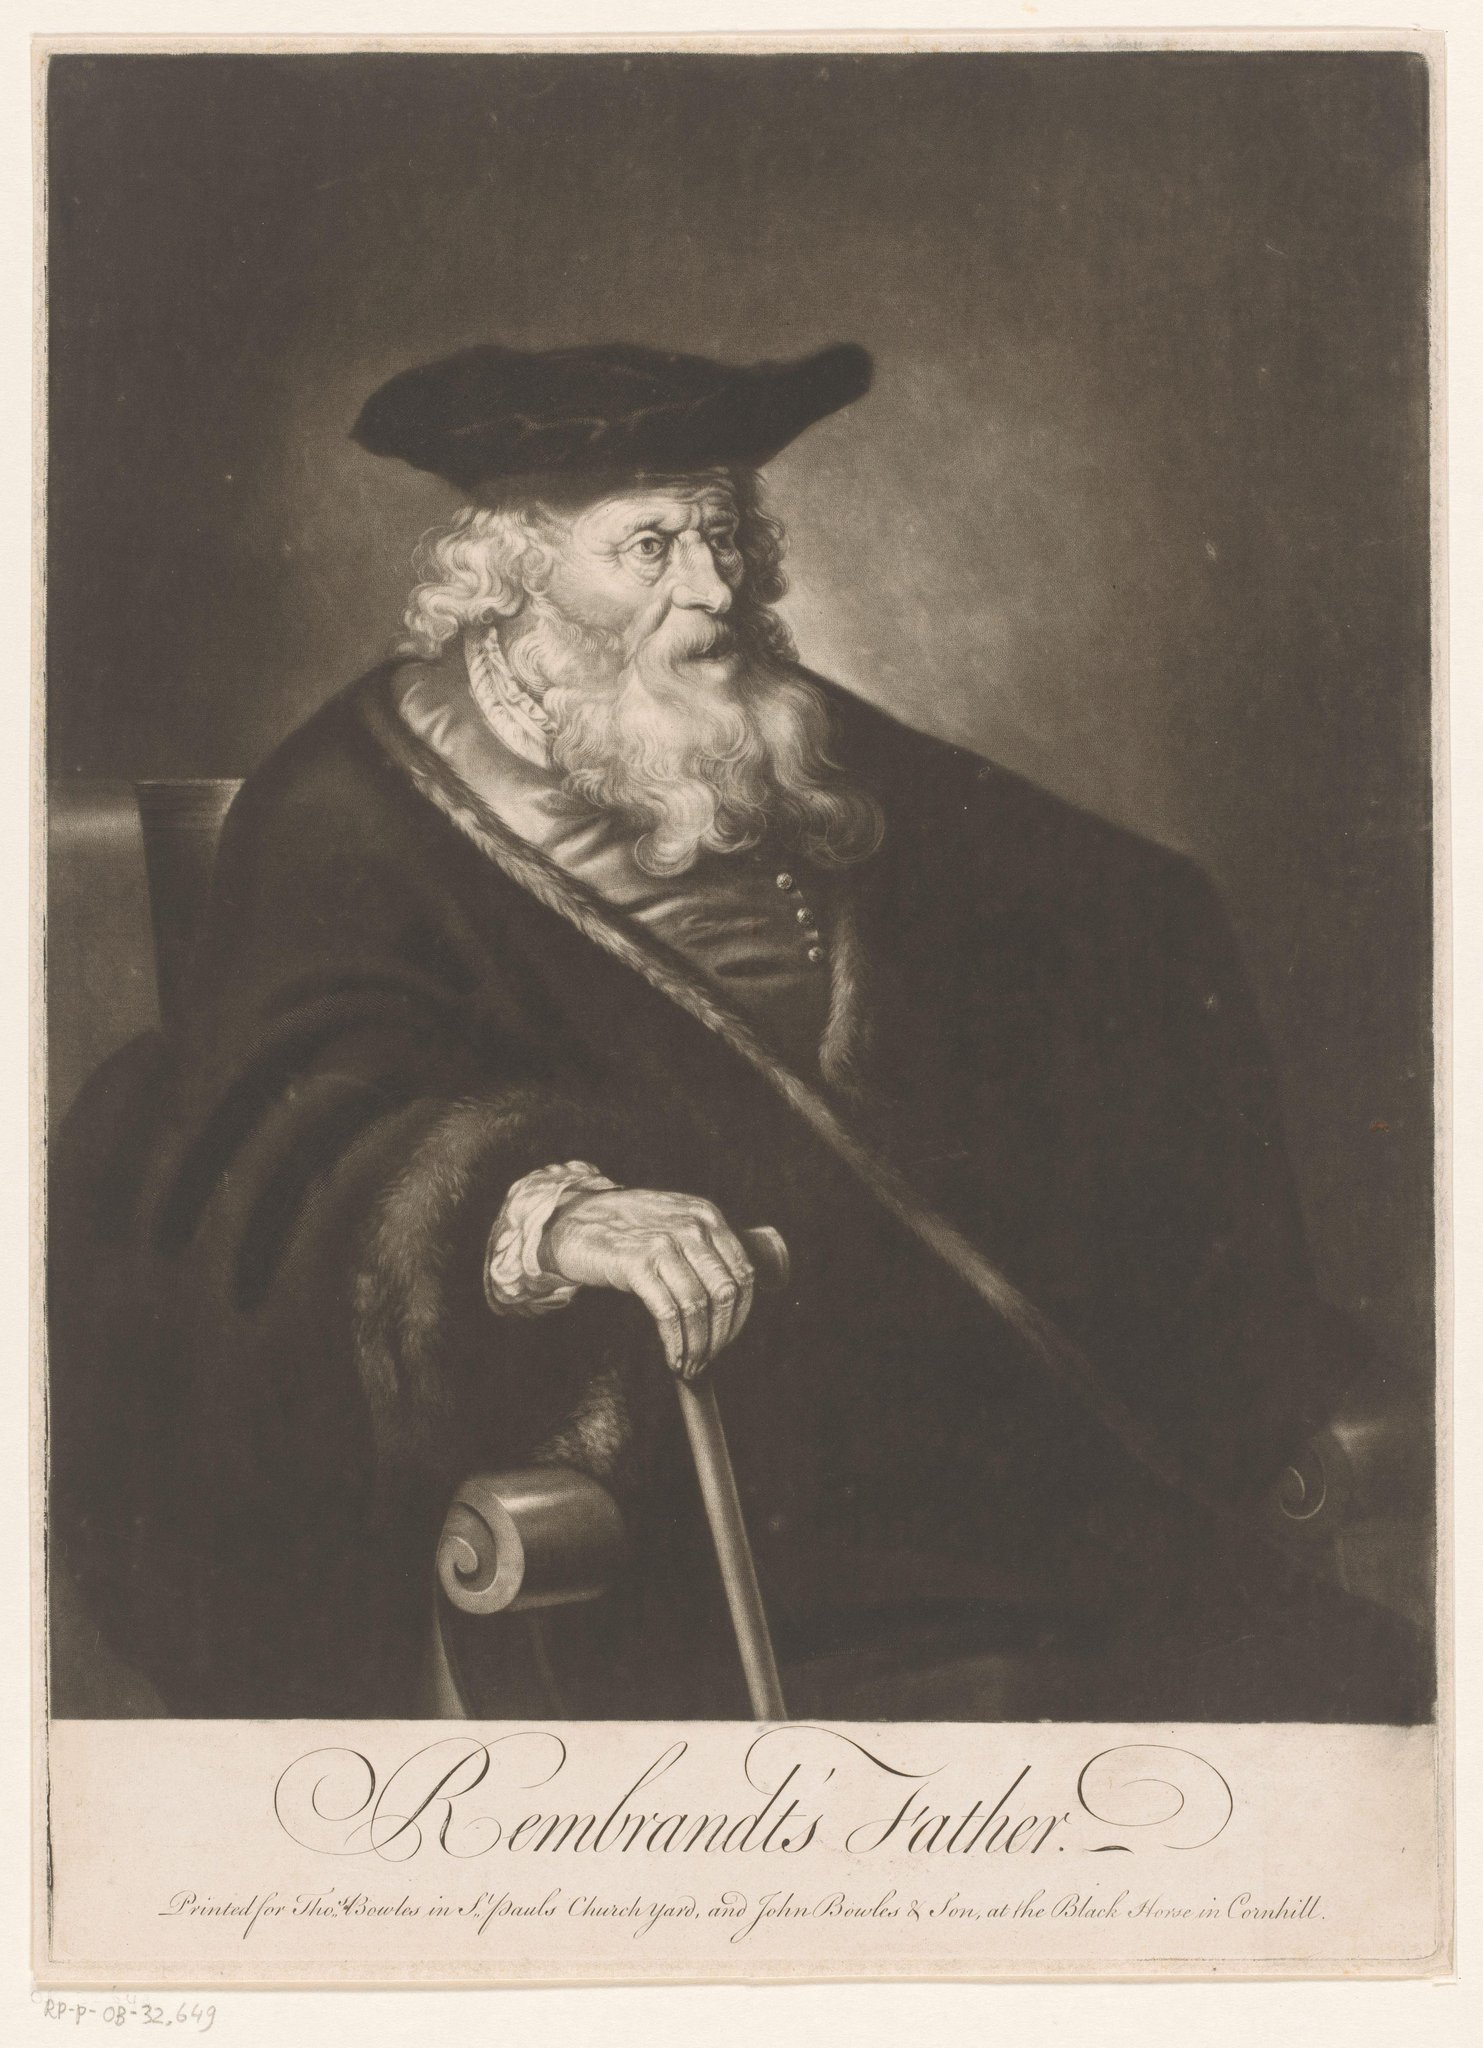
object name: print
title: Portret van een onbekende oude man, mogelijk Harmen Gerritsz. van Rijn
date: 1766-1767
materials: paper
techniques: mezzotint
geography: london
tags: historical persons, old man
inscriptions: collector's mark: Lugt 240